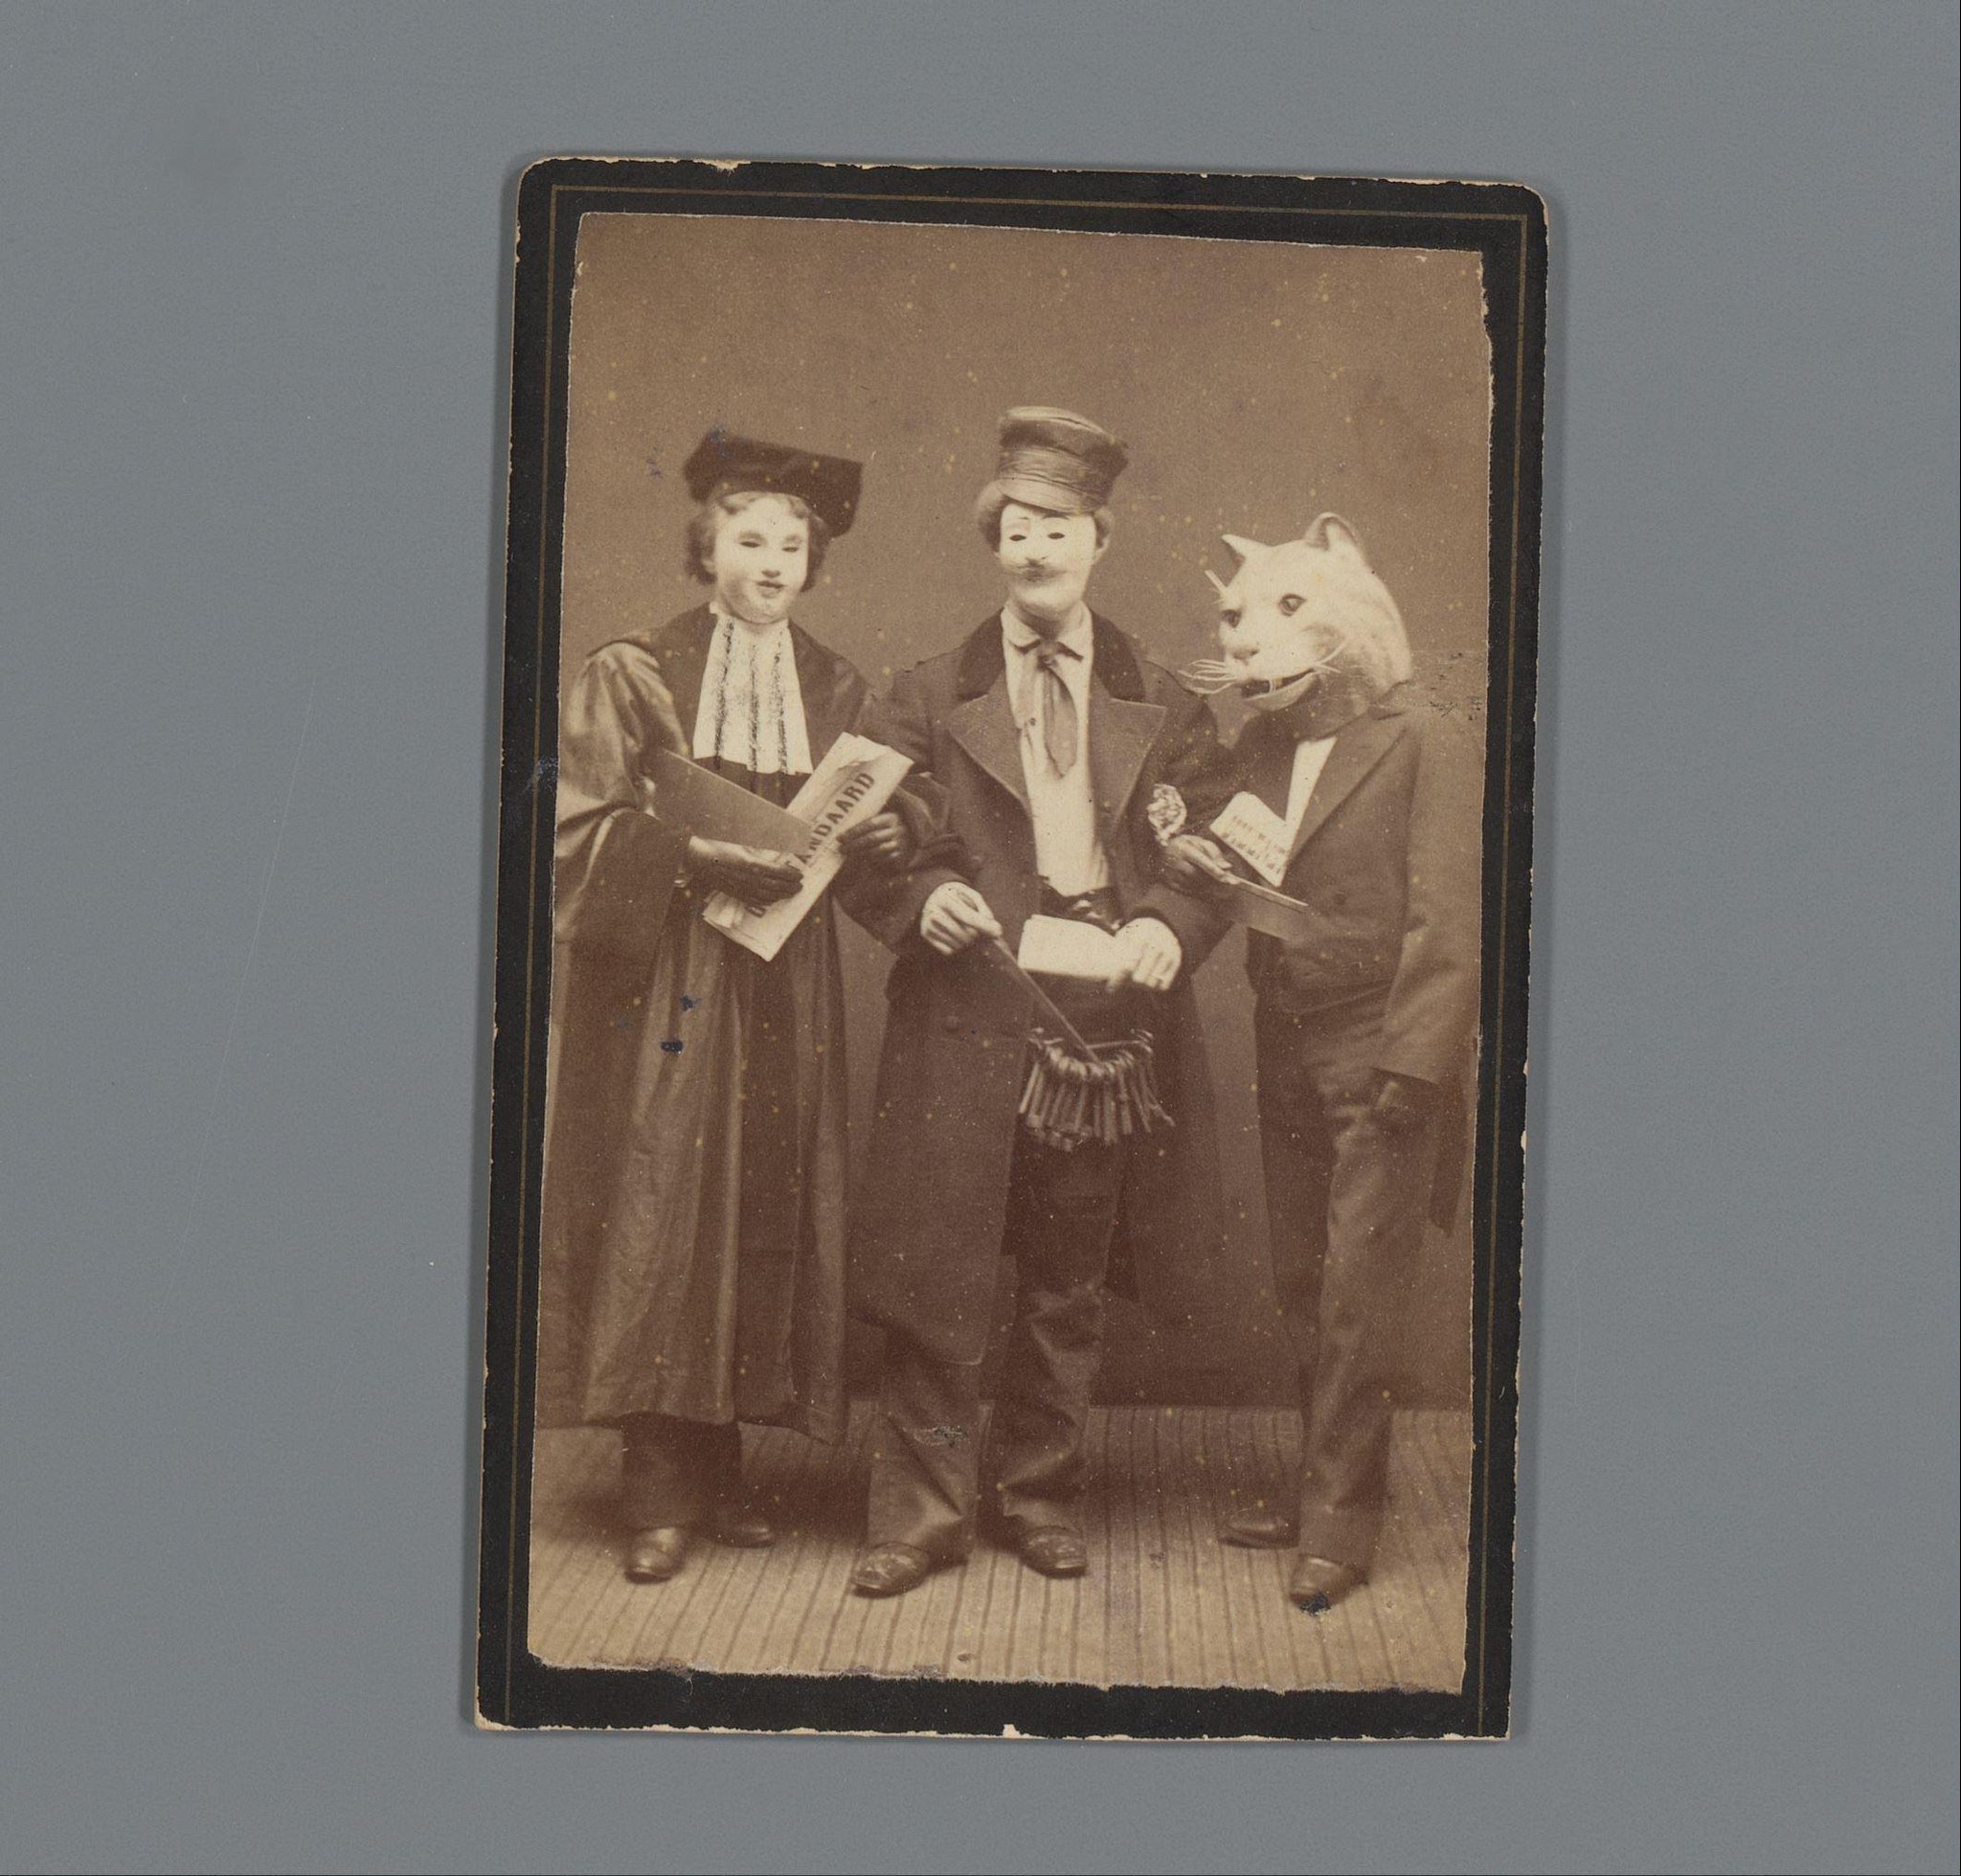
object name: photograph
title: Portret van drie onbekende gekostumeerde mannen met maskers, van voren gezien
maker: Anonymous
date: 1872-1889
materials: cardboard, paper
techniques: albumen print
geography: netherlands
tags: mask, party clothes, festive attire, anonymous historical person portrayed, netherlands